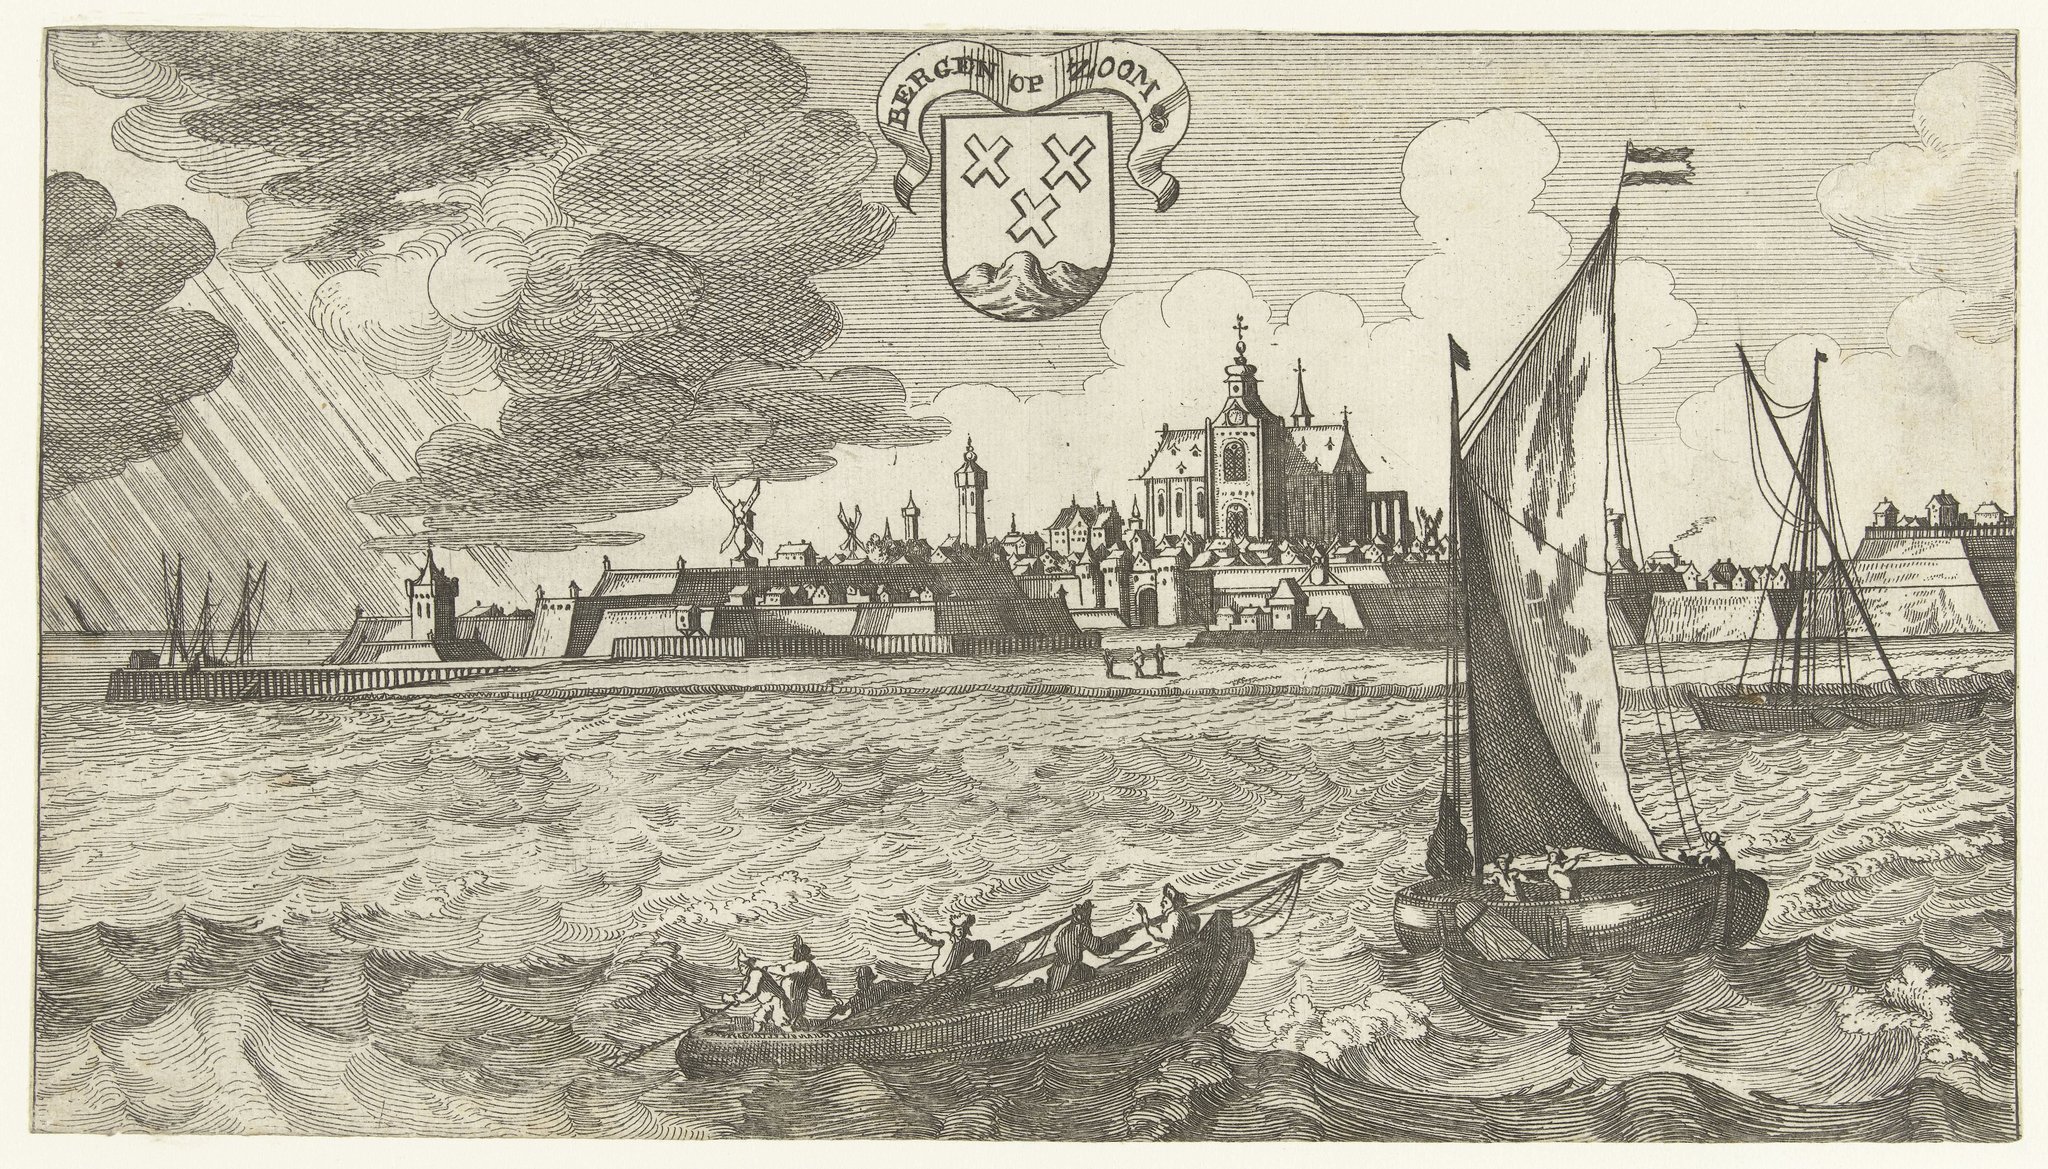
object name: print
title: Thooneel der Steden ende Sterckten van 't Vereenight Nederlandt met d'aengrensende Plaetsen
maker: gaspar bouttats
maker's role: print maker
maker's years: 1640-1695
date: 1679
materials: paper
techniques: etching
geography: antwerp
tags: prospect of city, town panorama, silhouette of city, bergen op zoom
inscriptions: inscription: ‘Bergen-op-Zoom’, collector's mark: Lugt 2228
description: Gezicht op de stad Bergen-op-Zoom. Op de voorgrond, buiten de stadsmuren, de rivier de Schelde met enkele vissersboten. Boven het stadsgezicht een cartouche met de naam van de stad en het wapenschild.